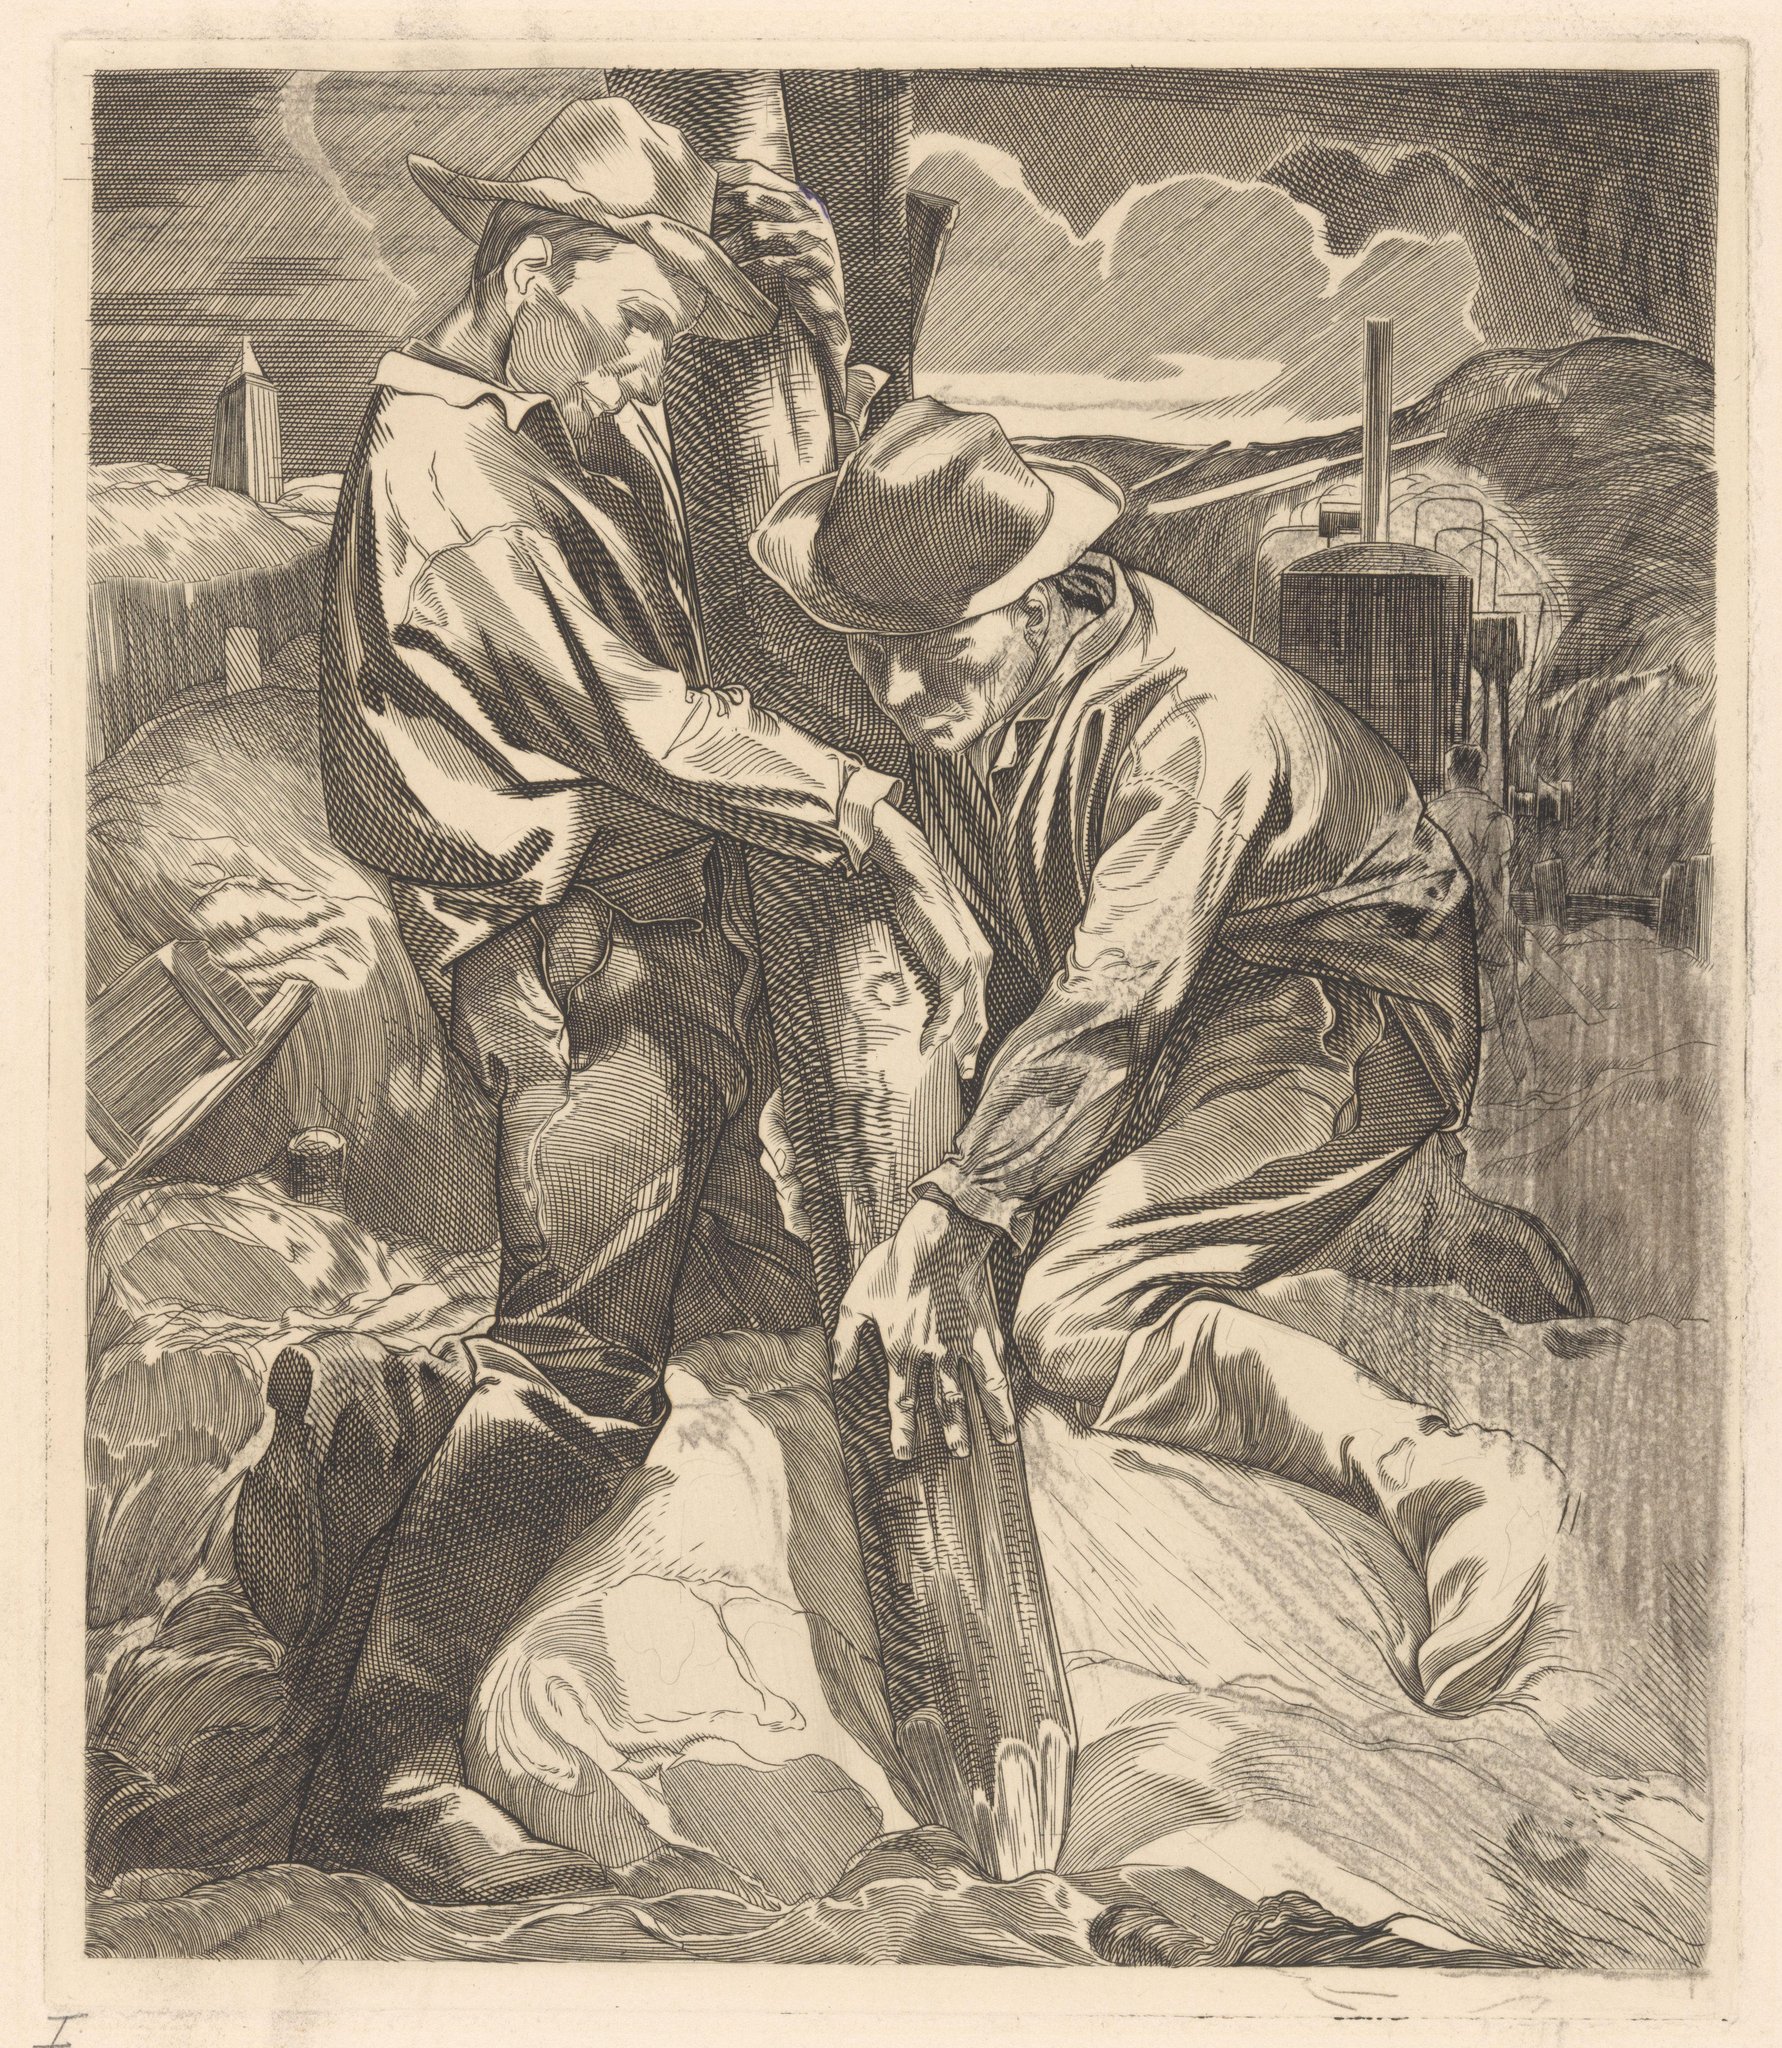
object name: print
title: Bouwarbeiders bezig met heiwerk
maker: johannes josephus aarts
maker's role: draughtsman, print maker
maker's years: 1871-1934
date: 1881-1934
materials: chalk, paper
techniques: engraving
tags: ramming, driving piles (~ building activities), working class, labourers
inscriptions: collector's mark: Lugt 2760, collector's mark: Lugt 2166, collector's mark: Lugt 2228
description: Twee arbeiders plaatsen samen een paal in de grond. Ze dragen beiden een hoed. Rechtsachter hen een machine en een andere arbeider.